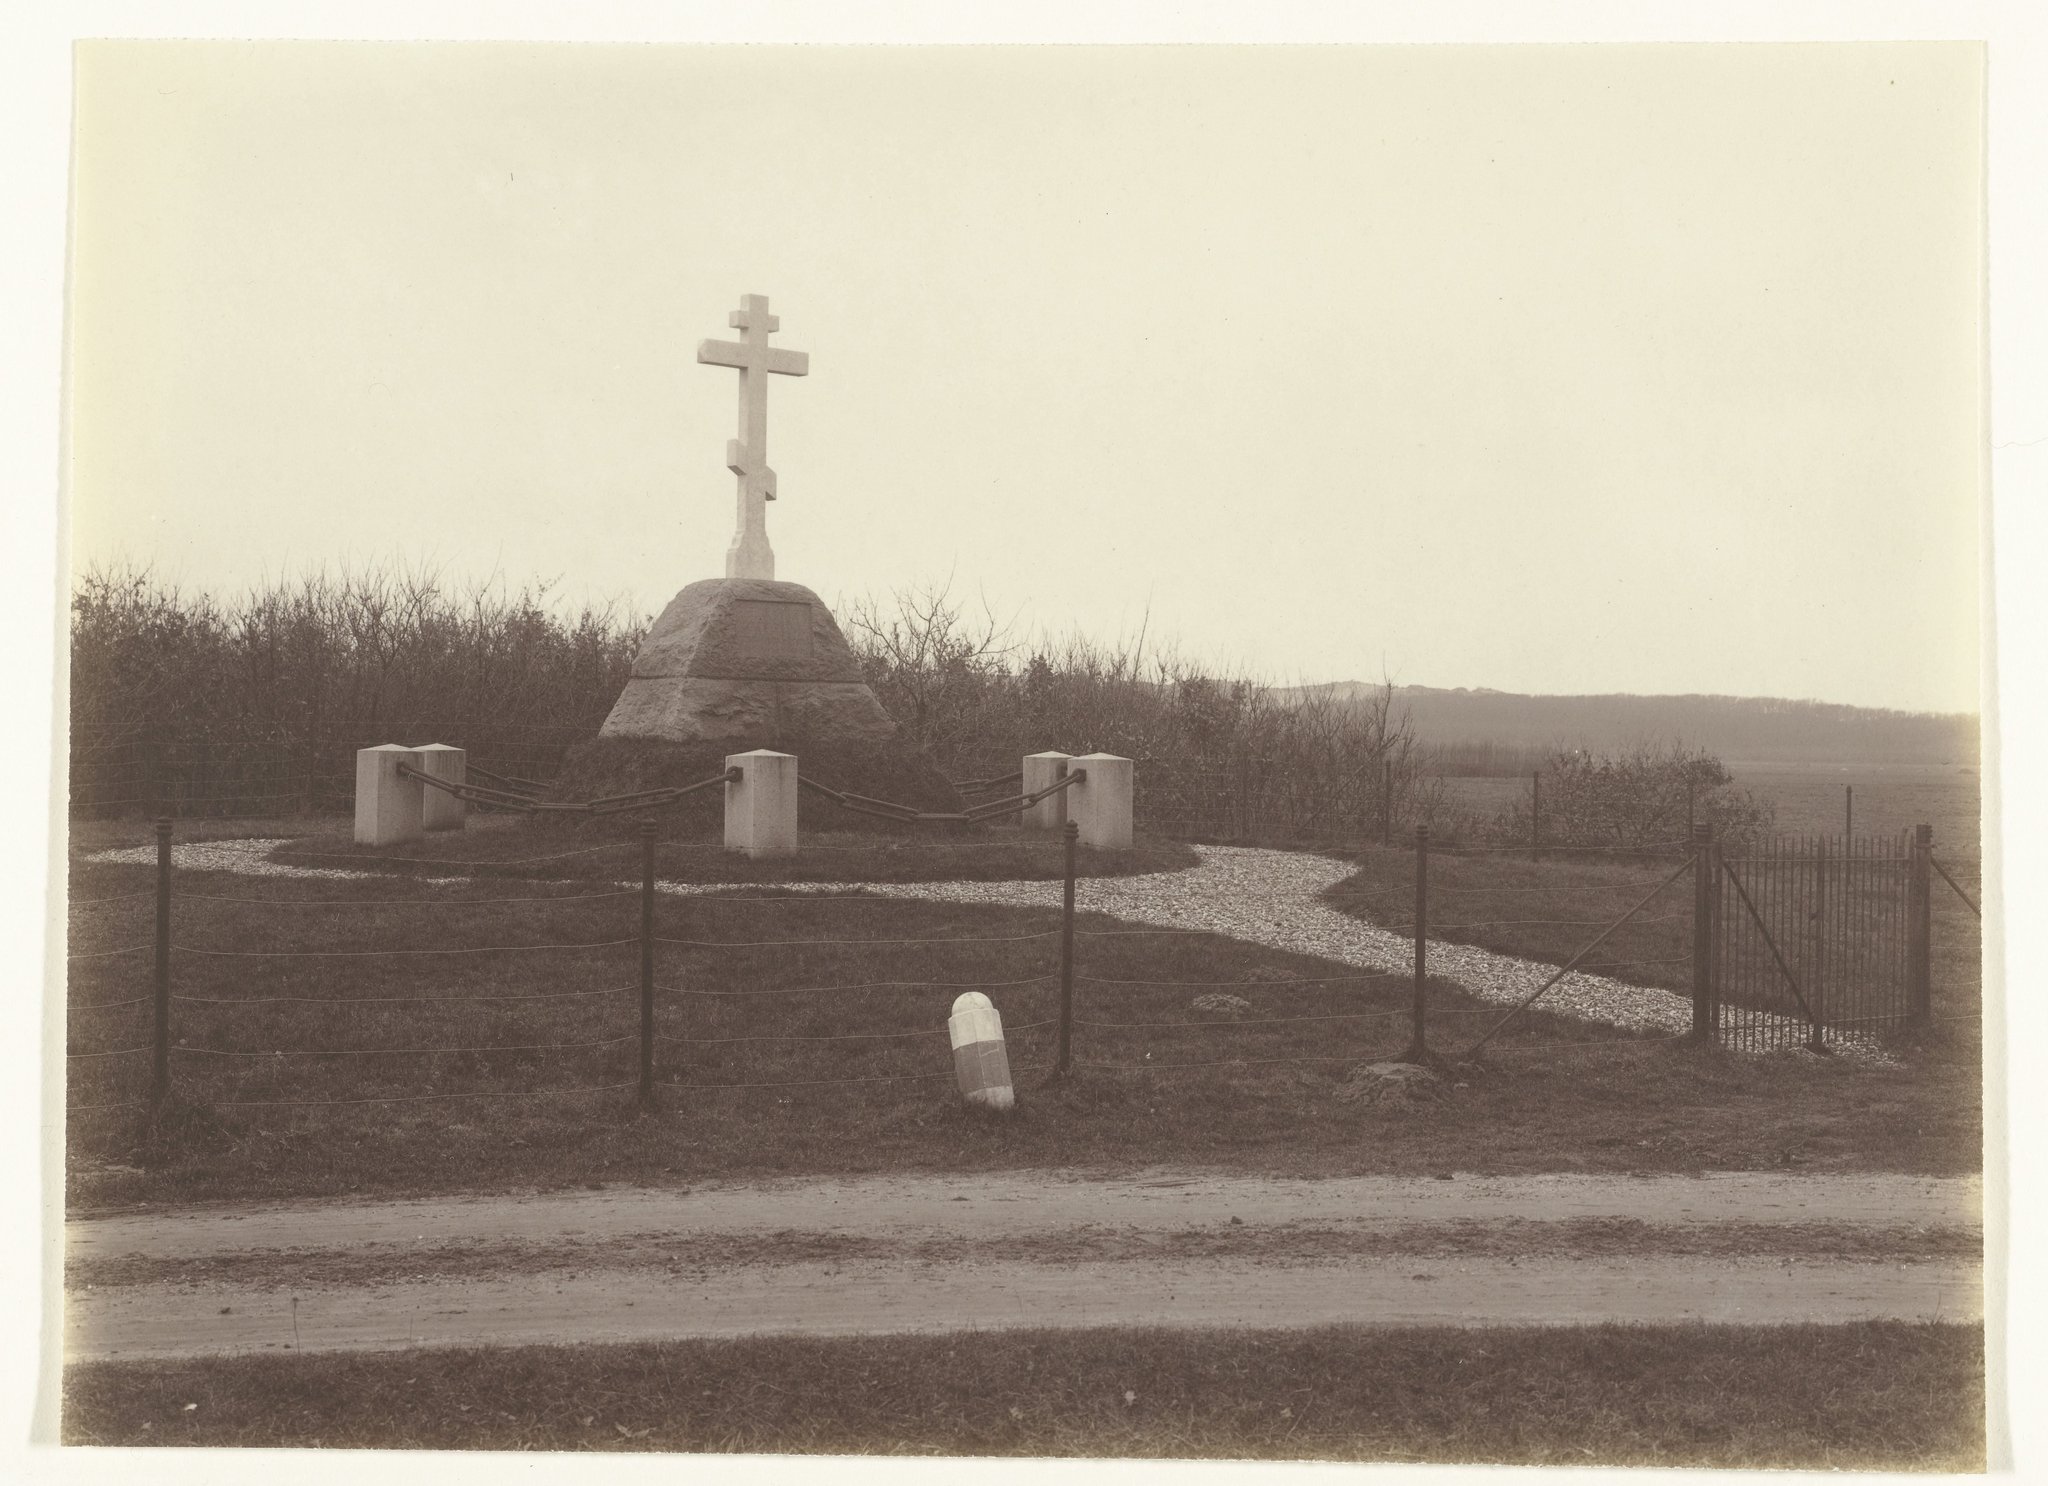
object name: photograph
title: Grafmonument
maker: richard tepe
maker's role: fotograaf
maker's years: 1864-1952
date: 1900-1930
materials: photographic support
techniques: salted paper print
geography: netherlands